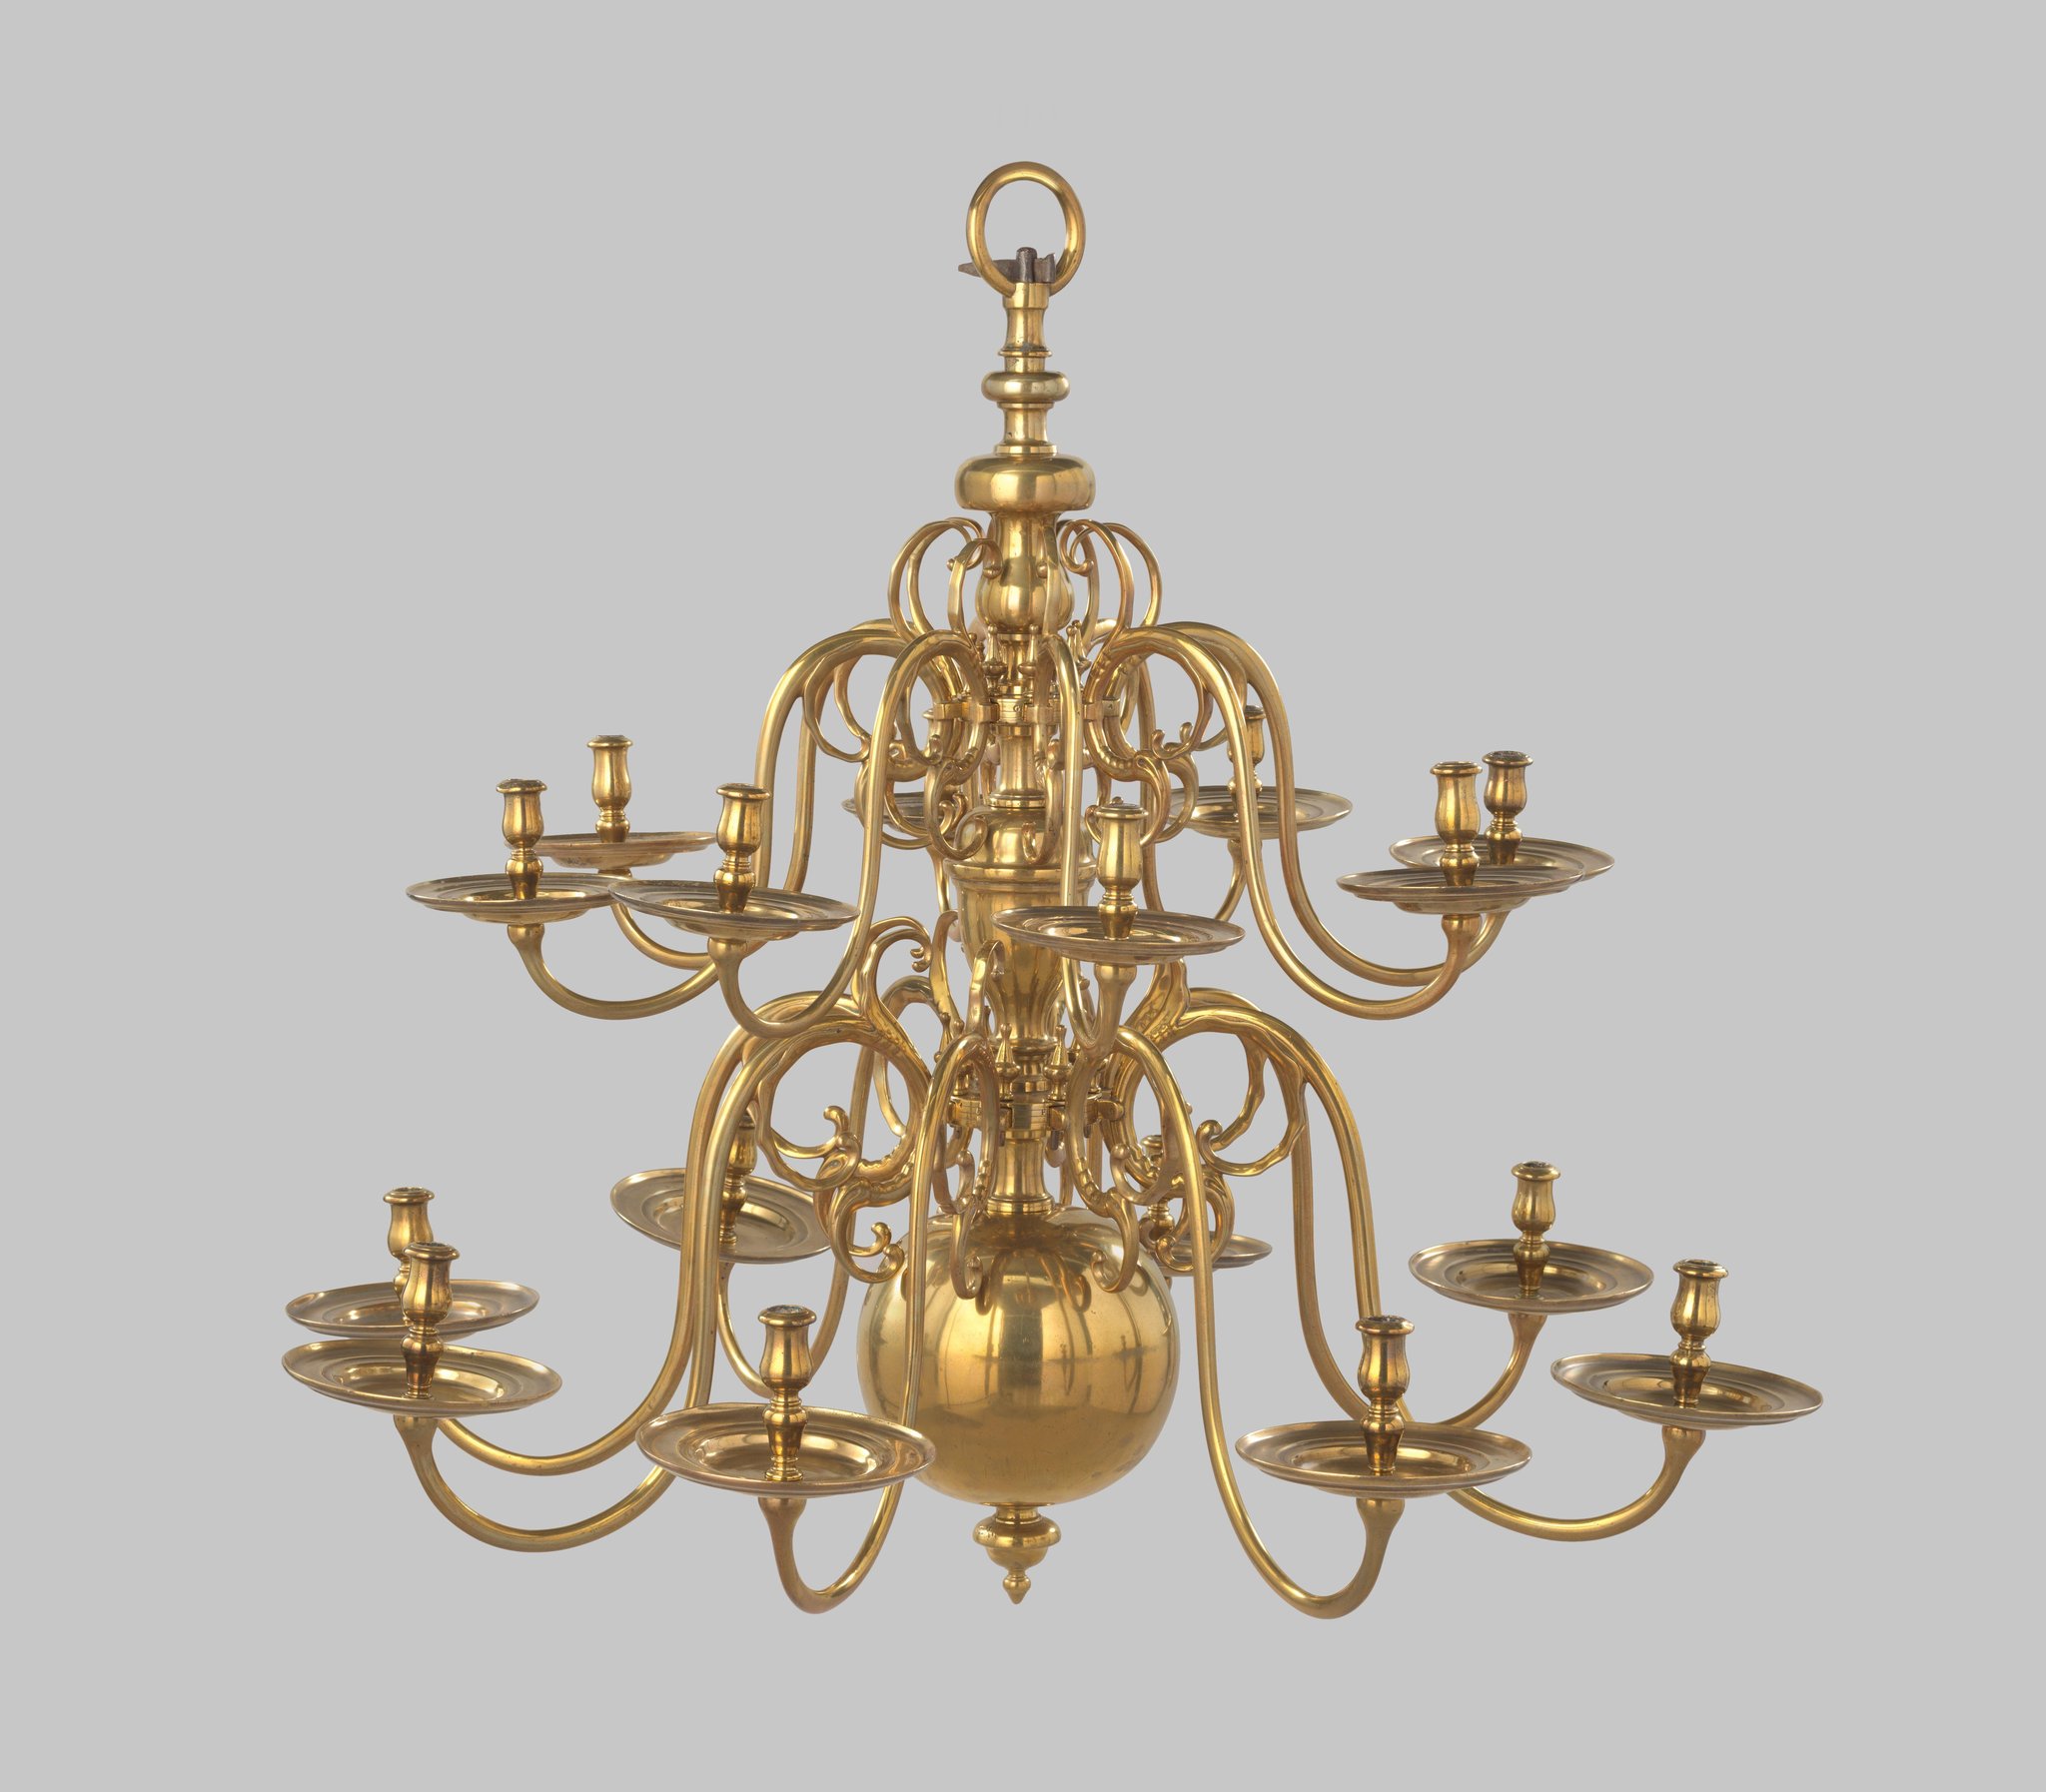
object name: chandelier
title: Arm van een kaarsenkroon in twee hoogten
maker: Anonymous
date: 1650-1675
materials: brass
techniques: screwed, turning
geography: amsterdam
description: De S-vormige arm is aan de stamzijde voorzien van een nok met een opening om deze met een pin in de standring te kunnen vastzetten. Bij de stam is de arm op het eind versierd met een gestileerde dolfijnenkop en met twee krullen, waarvan de vormgeving aan het kwabornament is ontleend. Naar buiten toe eindigt de arm in een verdikking, waarin een van een schroefdraad voorzien gat is aangebracht ter bevestiging van de kaarsenhouder met de vetvanger. De arm is met behulp van hetzelfde model gegoten als de overige armen van de krans en heeft dezelfe grootte. De kaarsenhouder heeft een ronde zich naar boven toe versmallende en in een uitstekende rand overgaande vaasvorm op balustervoet met een van een schroefdraad voorzien eind, waarin onderaan het centergat. De vetvanger is aan de bovenkant naar het midden toe één keer verdiept. Aan de onderkant is zij geprofileerd op de rand en rond het gat op het enigszins bolvormige midden. De vetvanger heeft telkens zijn eigen grootte en is met behulp van hetzelfde model gegoten als de overige vetvangers van deze krans. De pin is voorzien van een knop in vaasvorm. Dit is de zevende arm van de bovenste standring, genummerd op de nok met de letter G.